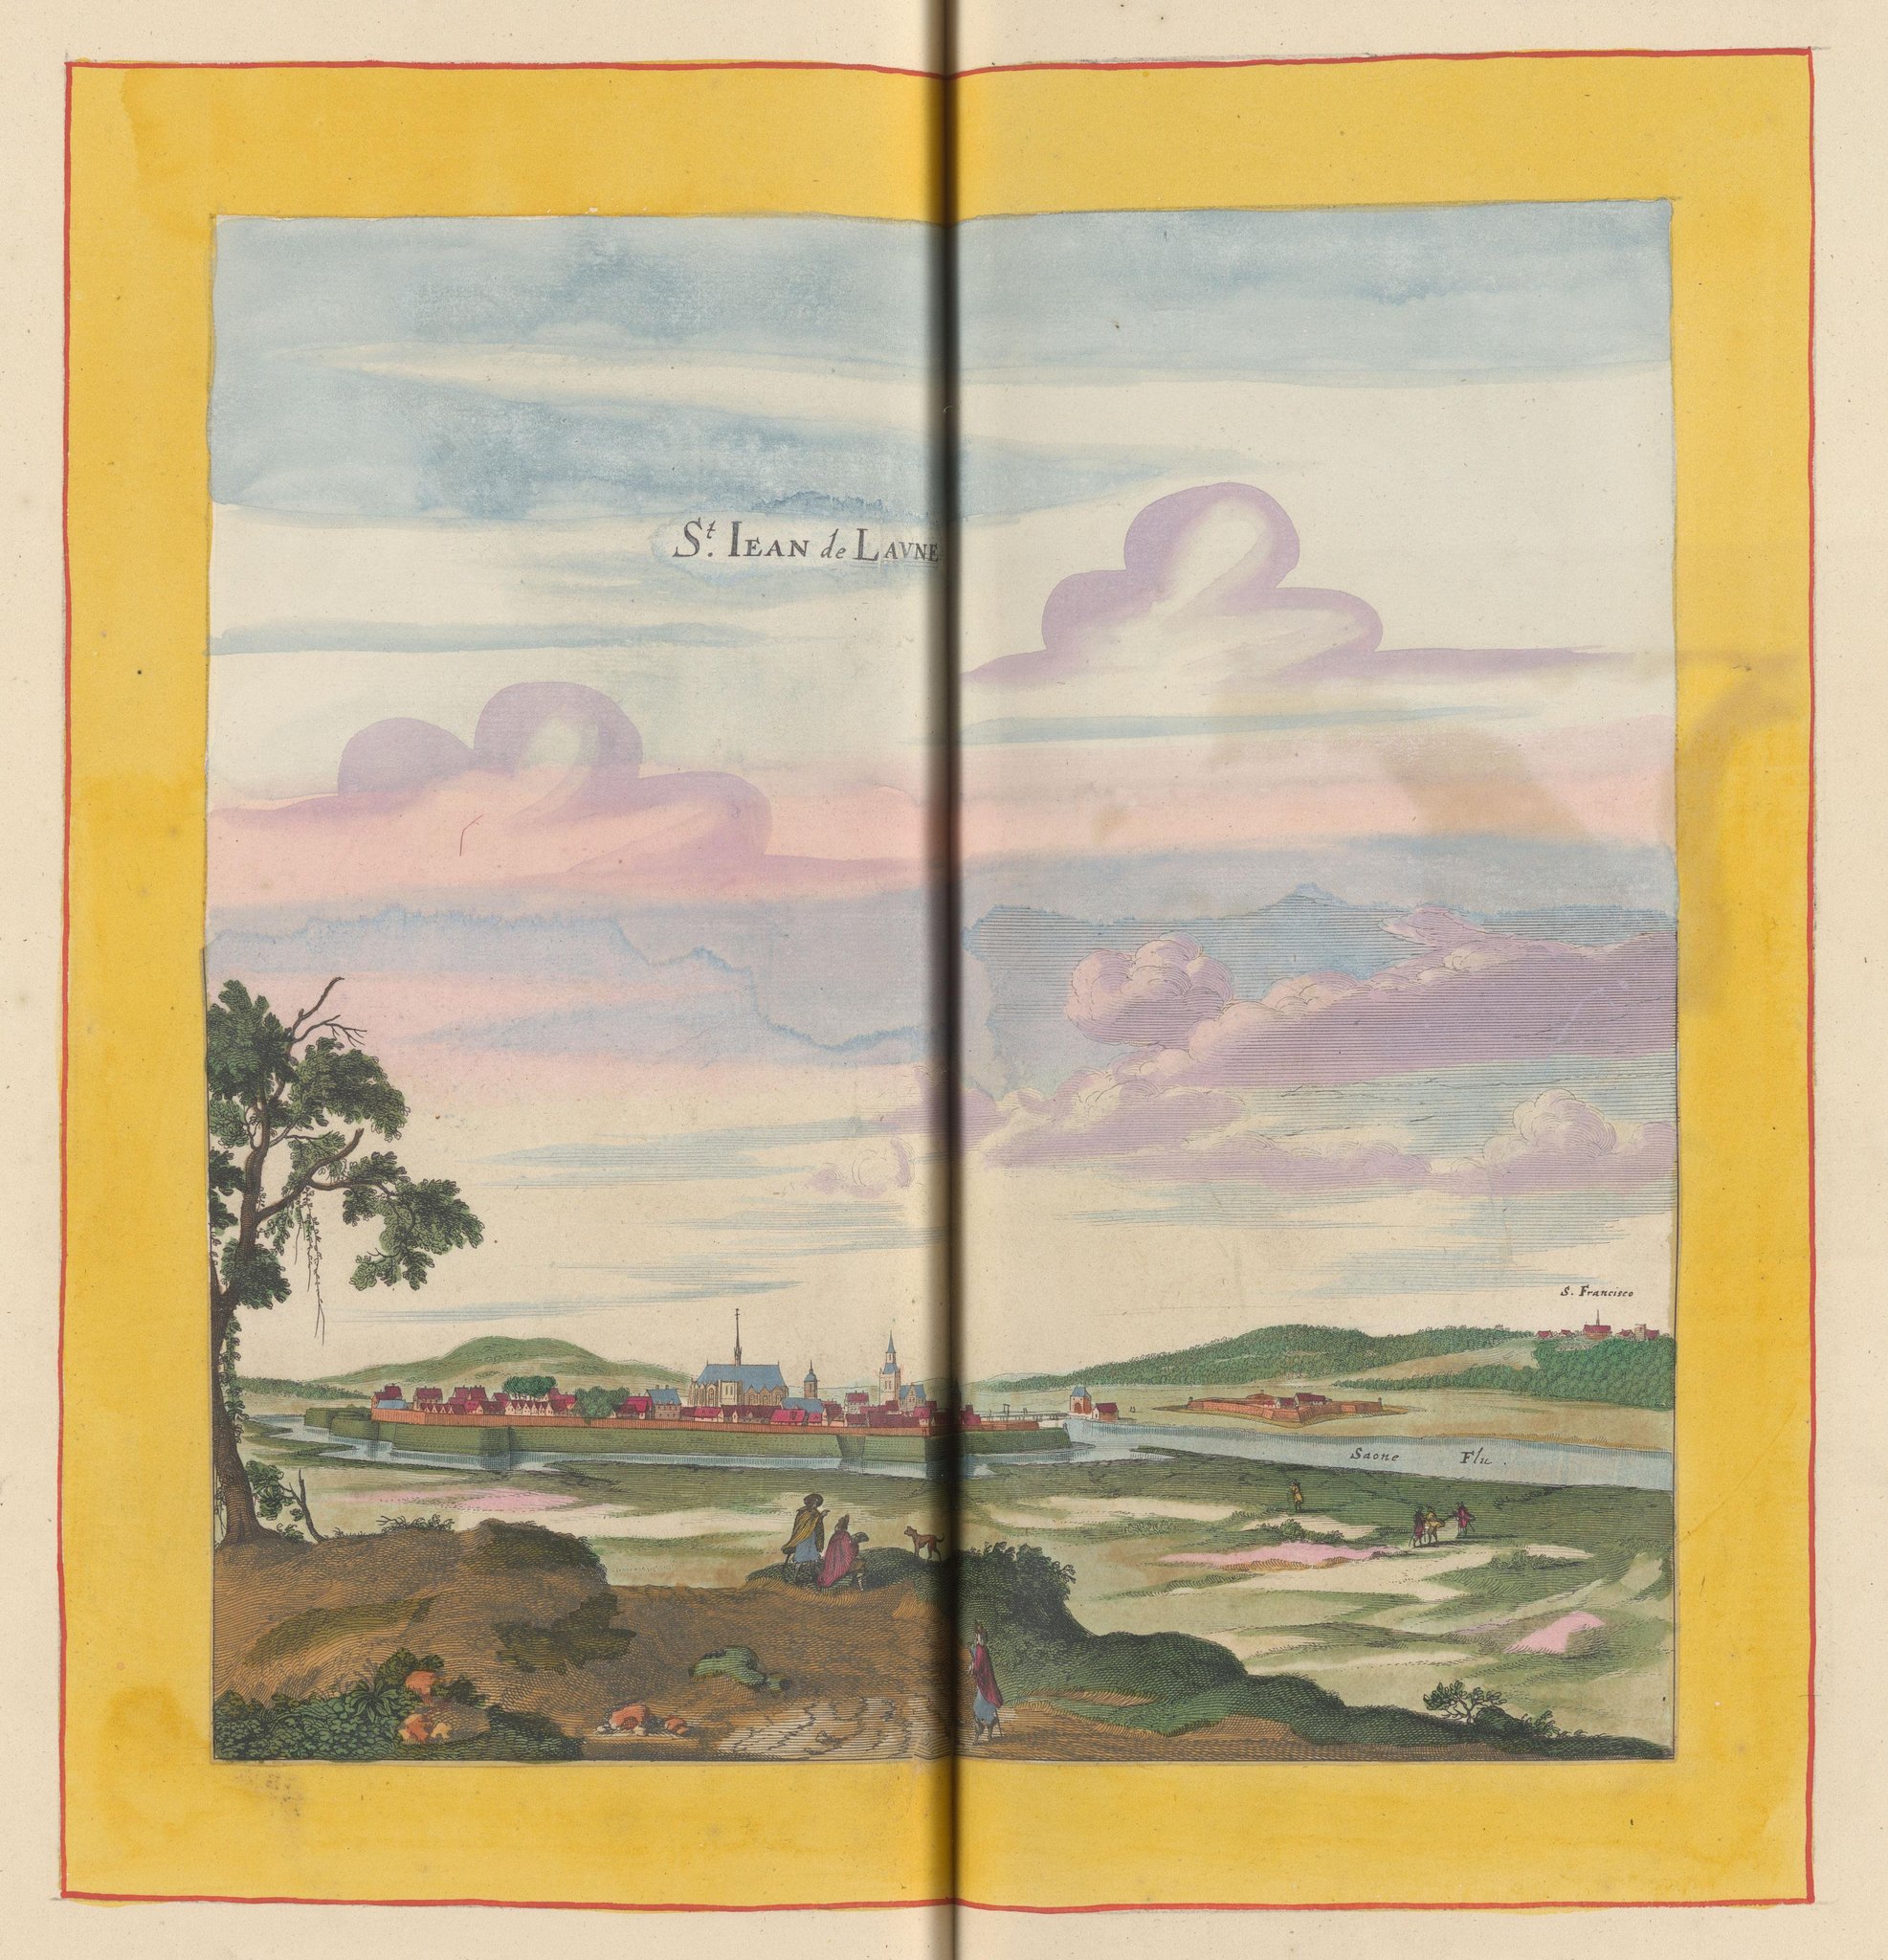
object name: album leaf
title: Gezicht op Saint-Jean-de-Losne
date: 1656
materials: paper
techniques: engraving, etching, hand coloring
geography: the hague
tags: maps of cities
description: Prent uit: Zeiller, Martin. Topographia Galliae. 13 dln. Frankfurt: Caspar Merian, 1656, dl. 4, na p. 18.